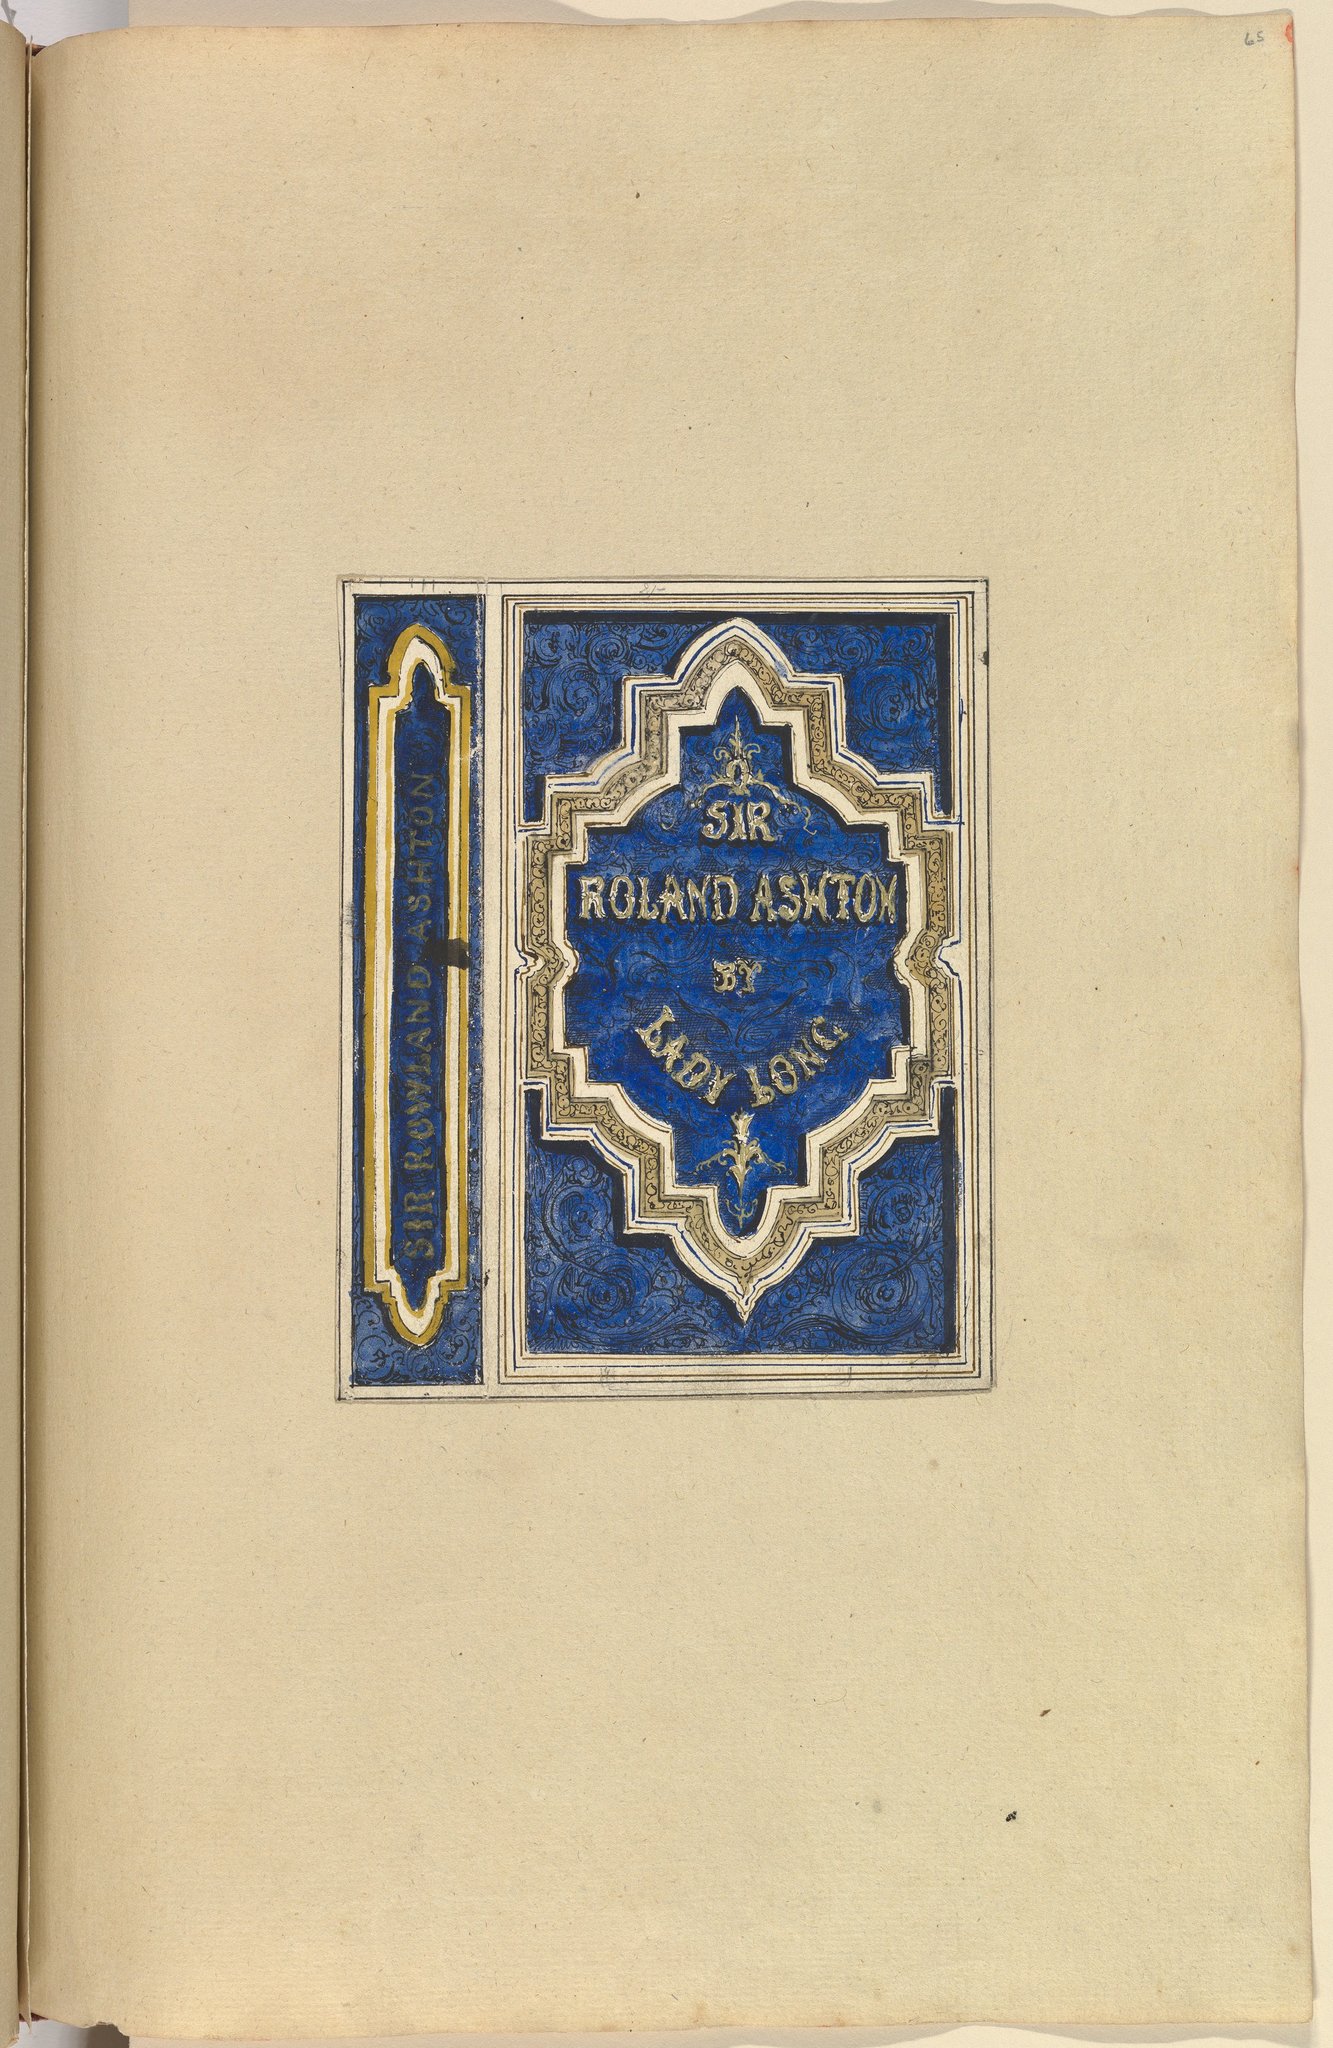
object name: drawing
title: Design for Bookcover, Sir Roland Ashton, by Lady Long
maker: alfred henry forrester [alfred crowquill]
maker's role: artist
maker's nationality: british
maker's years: 1804-1872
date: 1845-1870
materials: ink, watercolor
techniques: pen